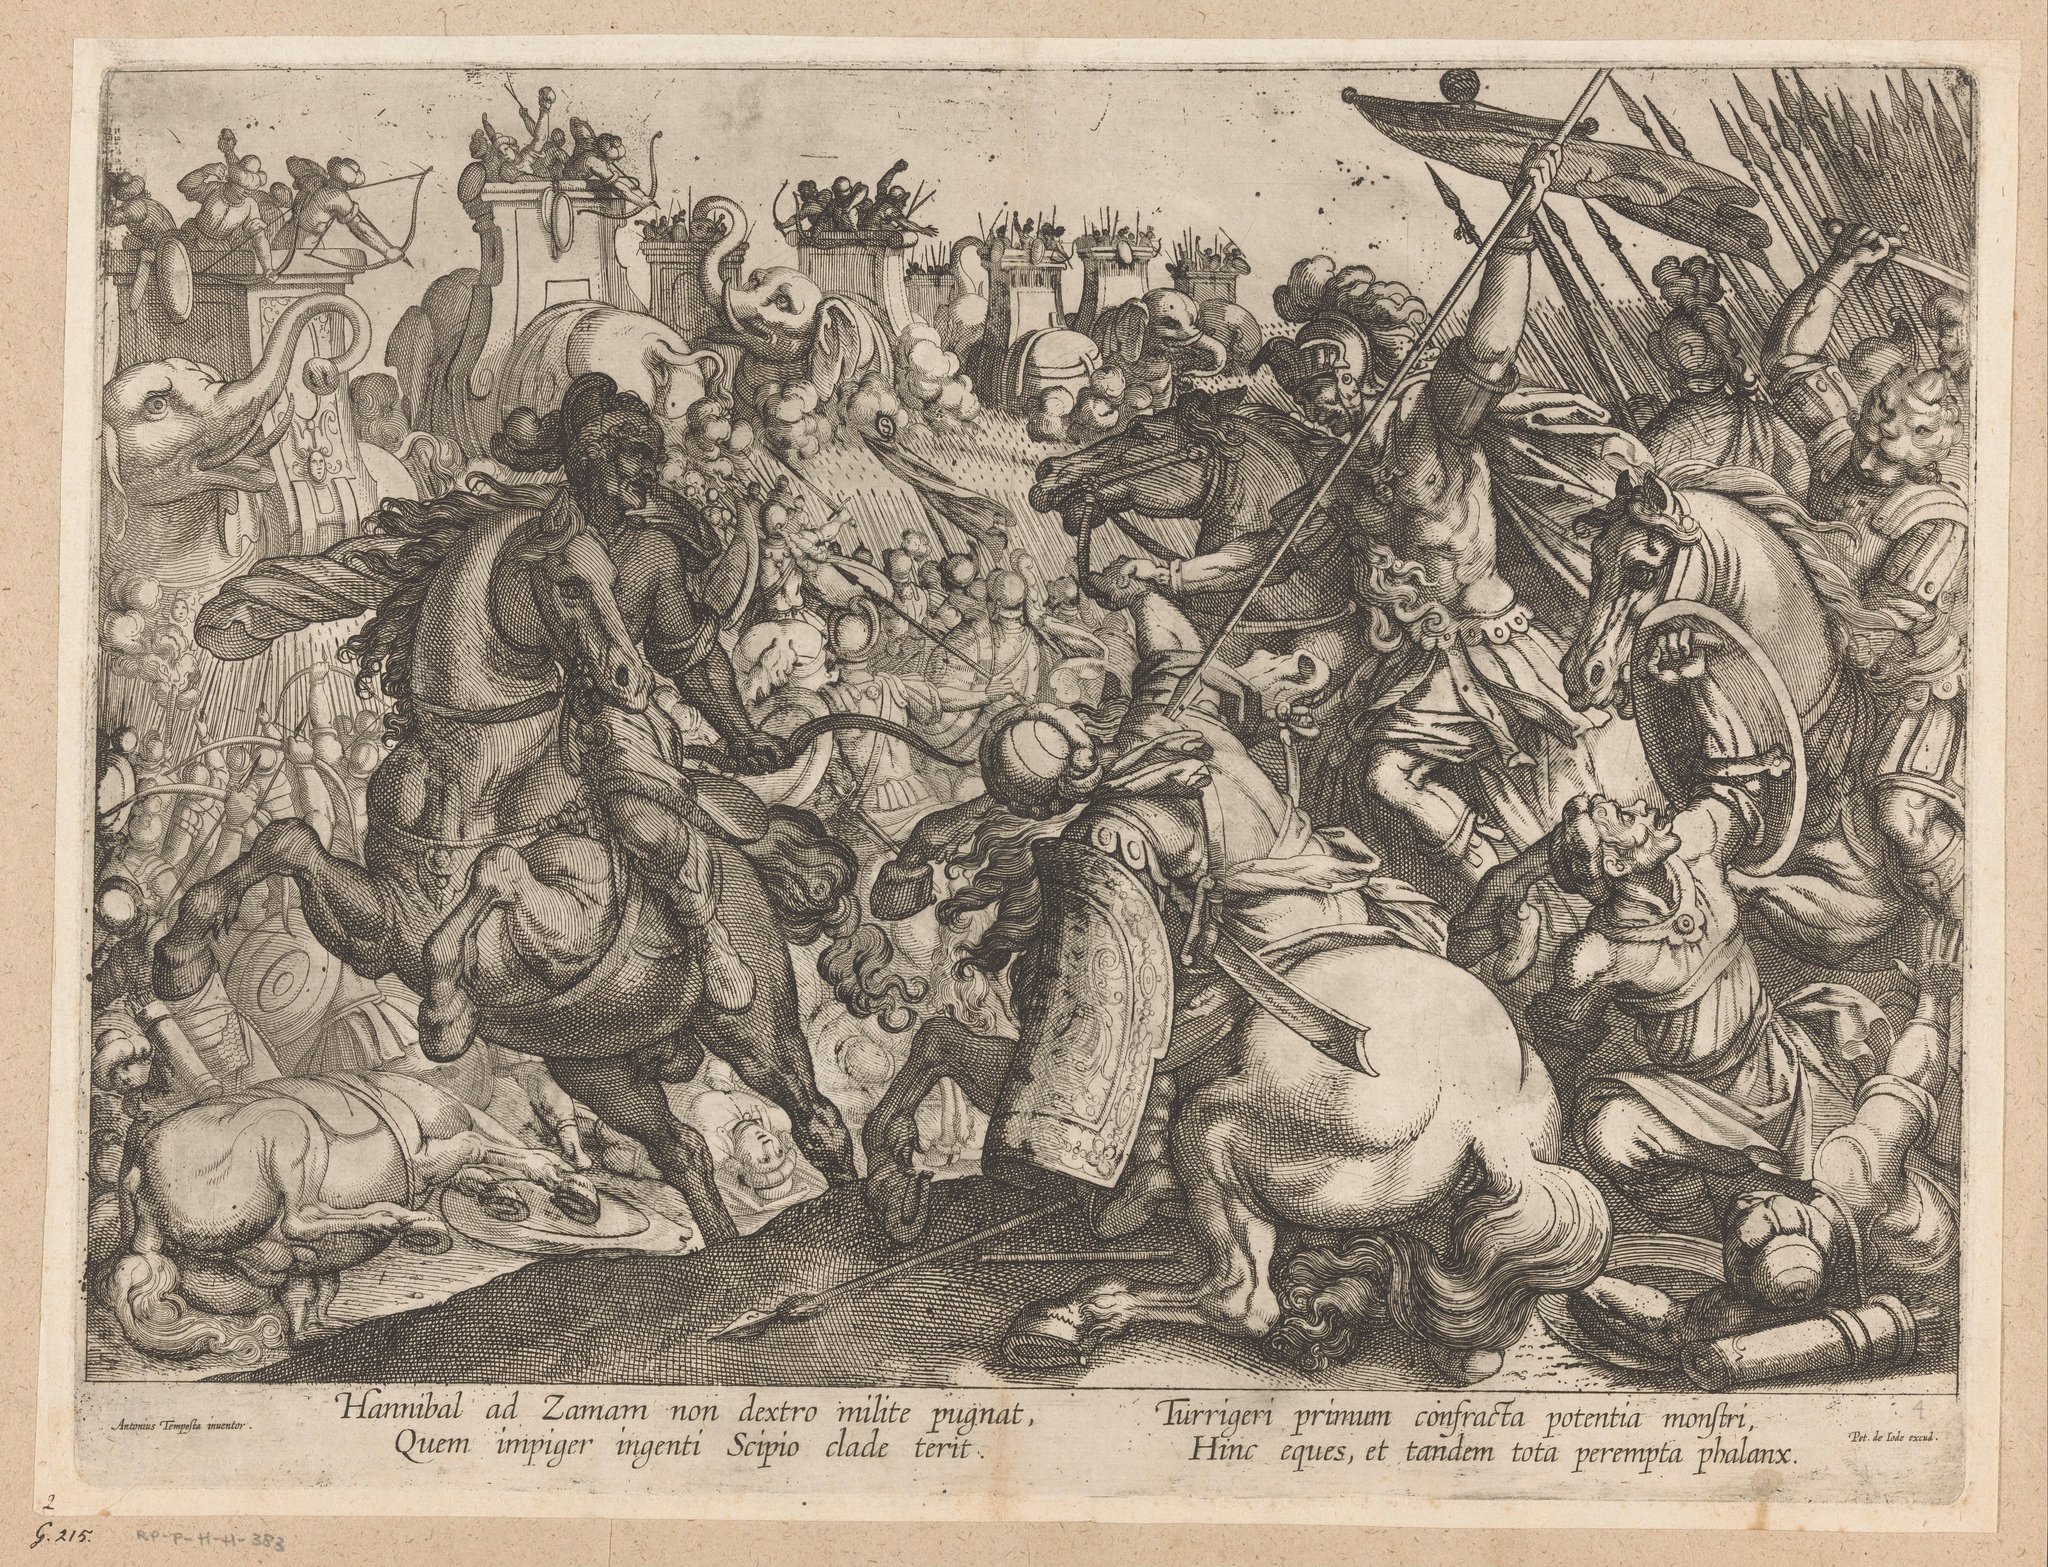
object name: print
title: Leger van Scipio Africanus in strijd met het leger van Hannibal Barkas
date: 1620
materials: paper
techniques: etching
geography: italy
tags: rome, politician, battle, (story of) p. cornelius scipio africanus major, warfare; military affairs (+ cavalry, horsemen), the soldier; the soldier's life, (story of) hannibal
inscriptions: collector's mark: Lugt 11, number: ‘2’, collector's mark: ‘Hinloopen’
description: Een kluwen van soldaten tijdens een hevige strijd. Op de voorgrond Scipio Africanus en zijn leger. Op de achtergrond de soldaten van Hannibal Barkas op olifanten. Versregels in het Latijn in ondermarge.